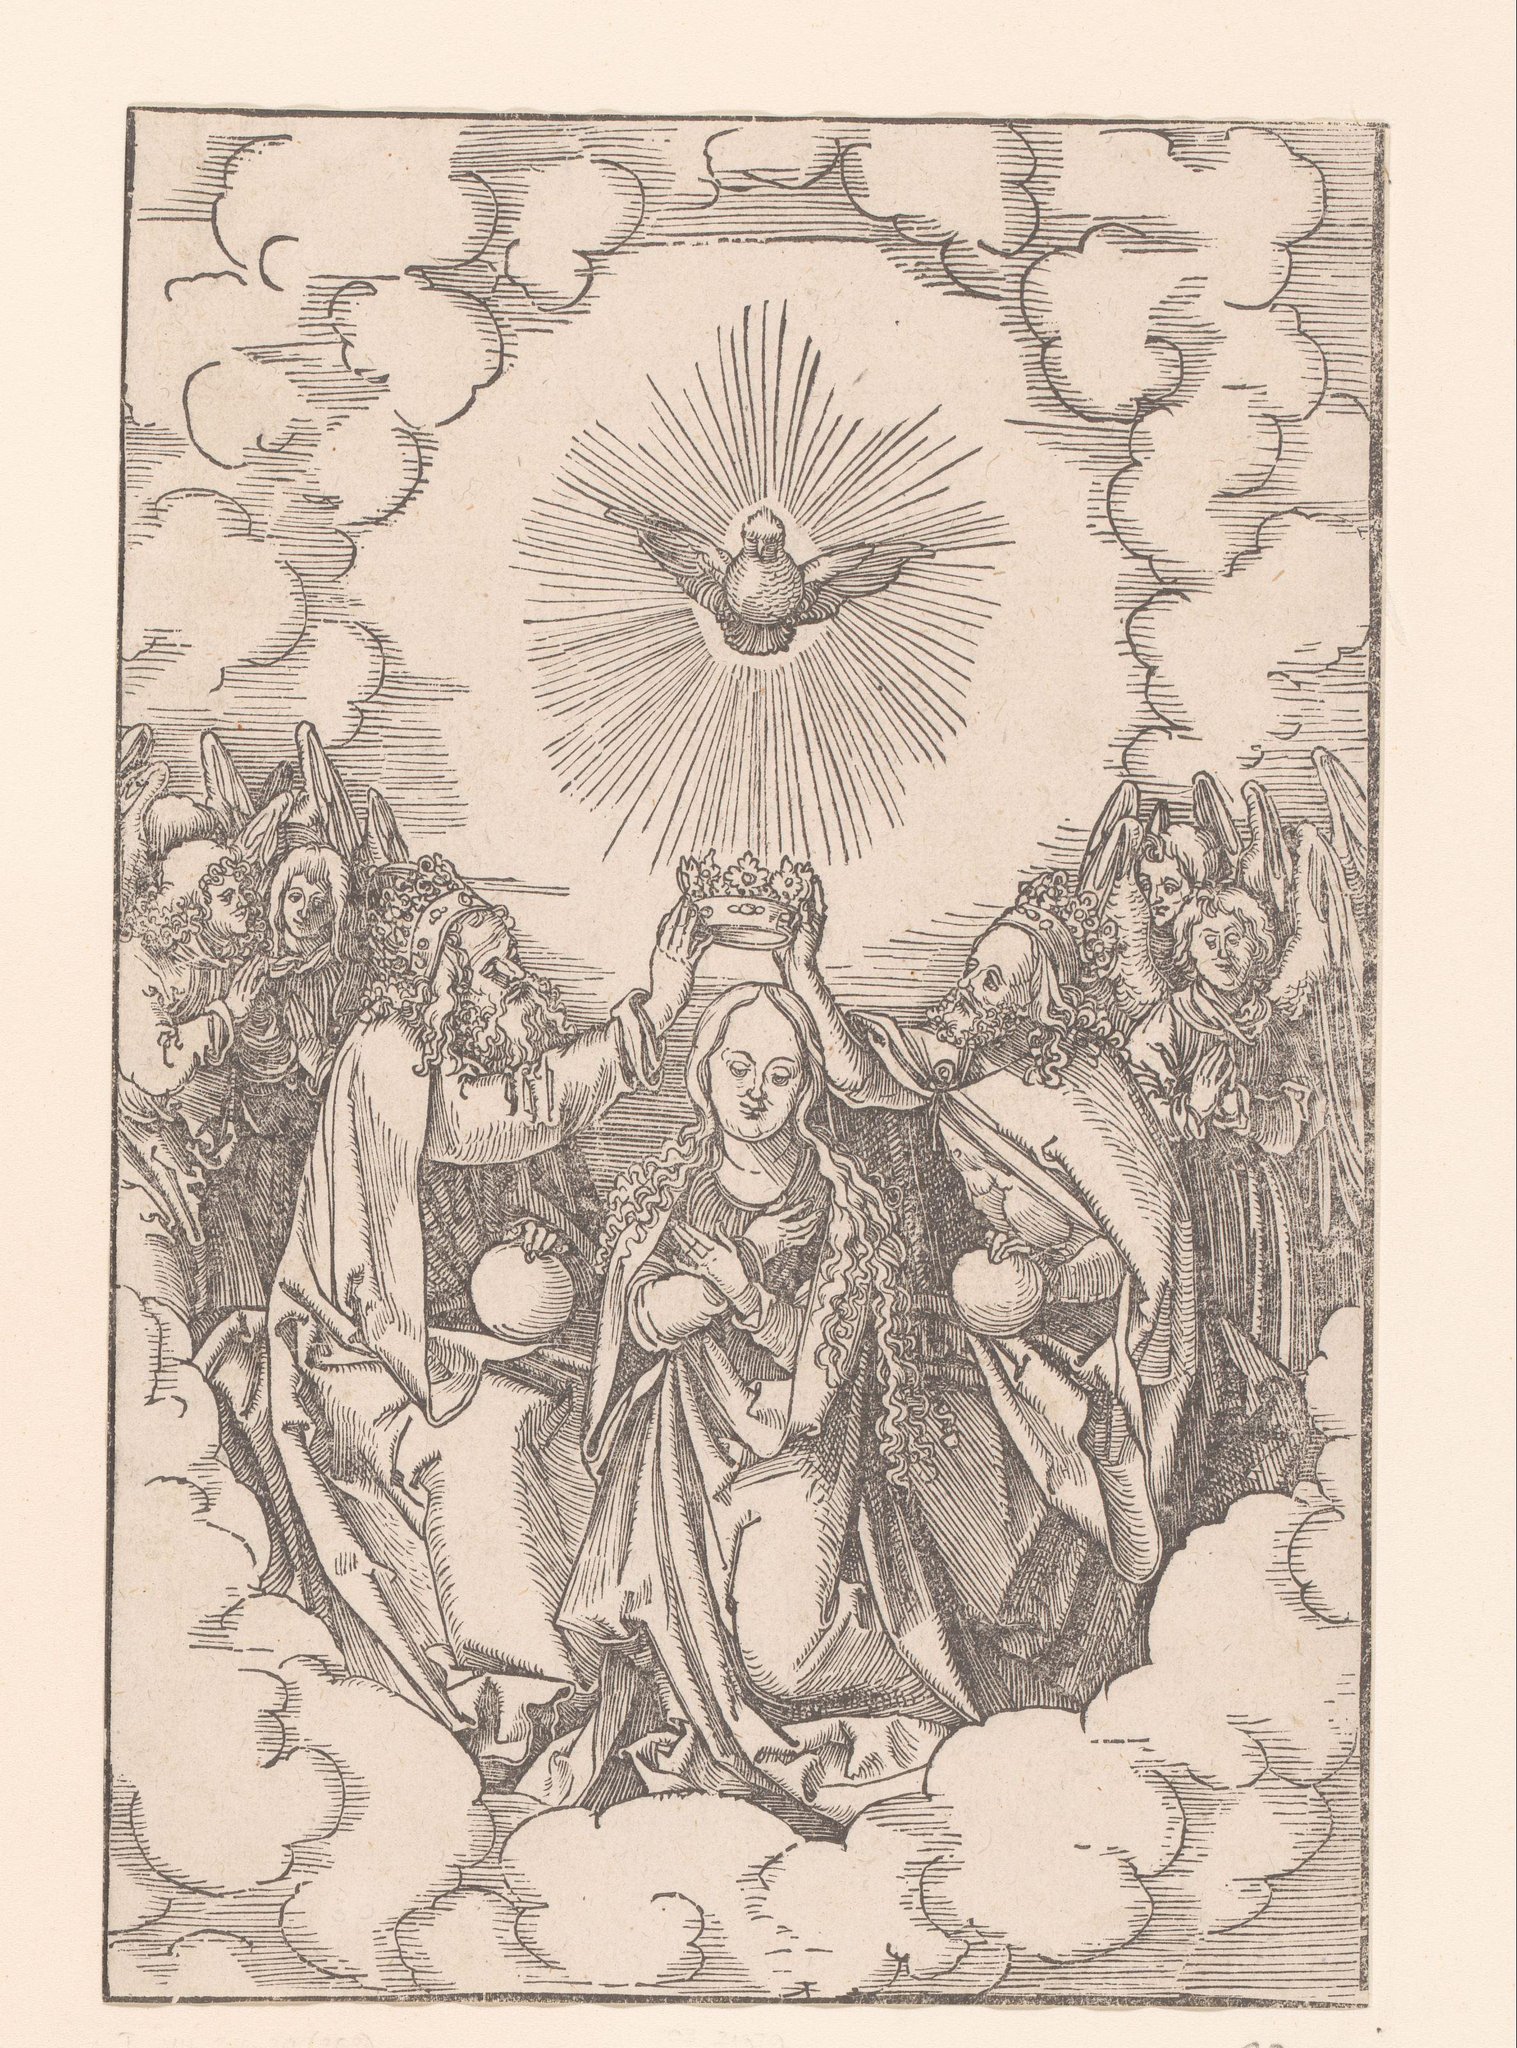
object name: book illustration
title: Kroning van Maria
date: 1506-1507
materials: paper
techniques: woodcut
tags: the christ-child crowning mary ~ madonna-representations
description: Prent voor het eerst gebruikt in: Speculum Passionis. Neurenberg: Ulrich Pinder, 1507.